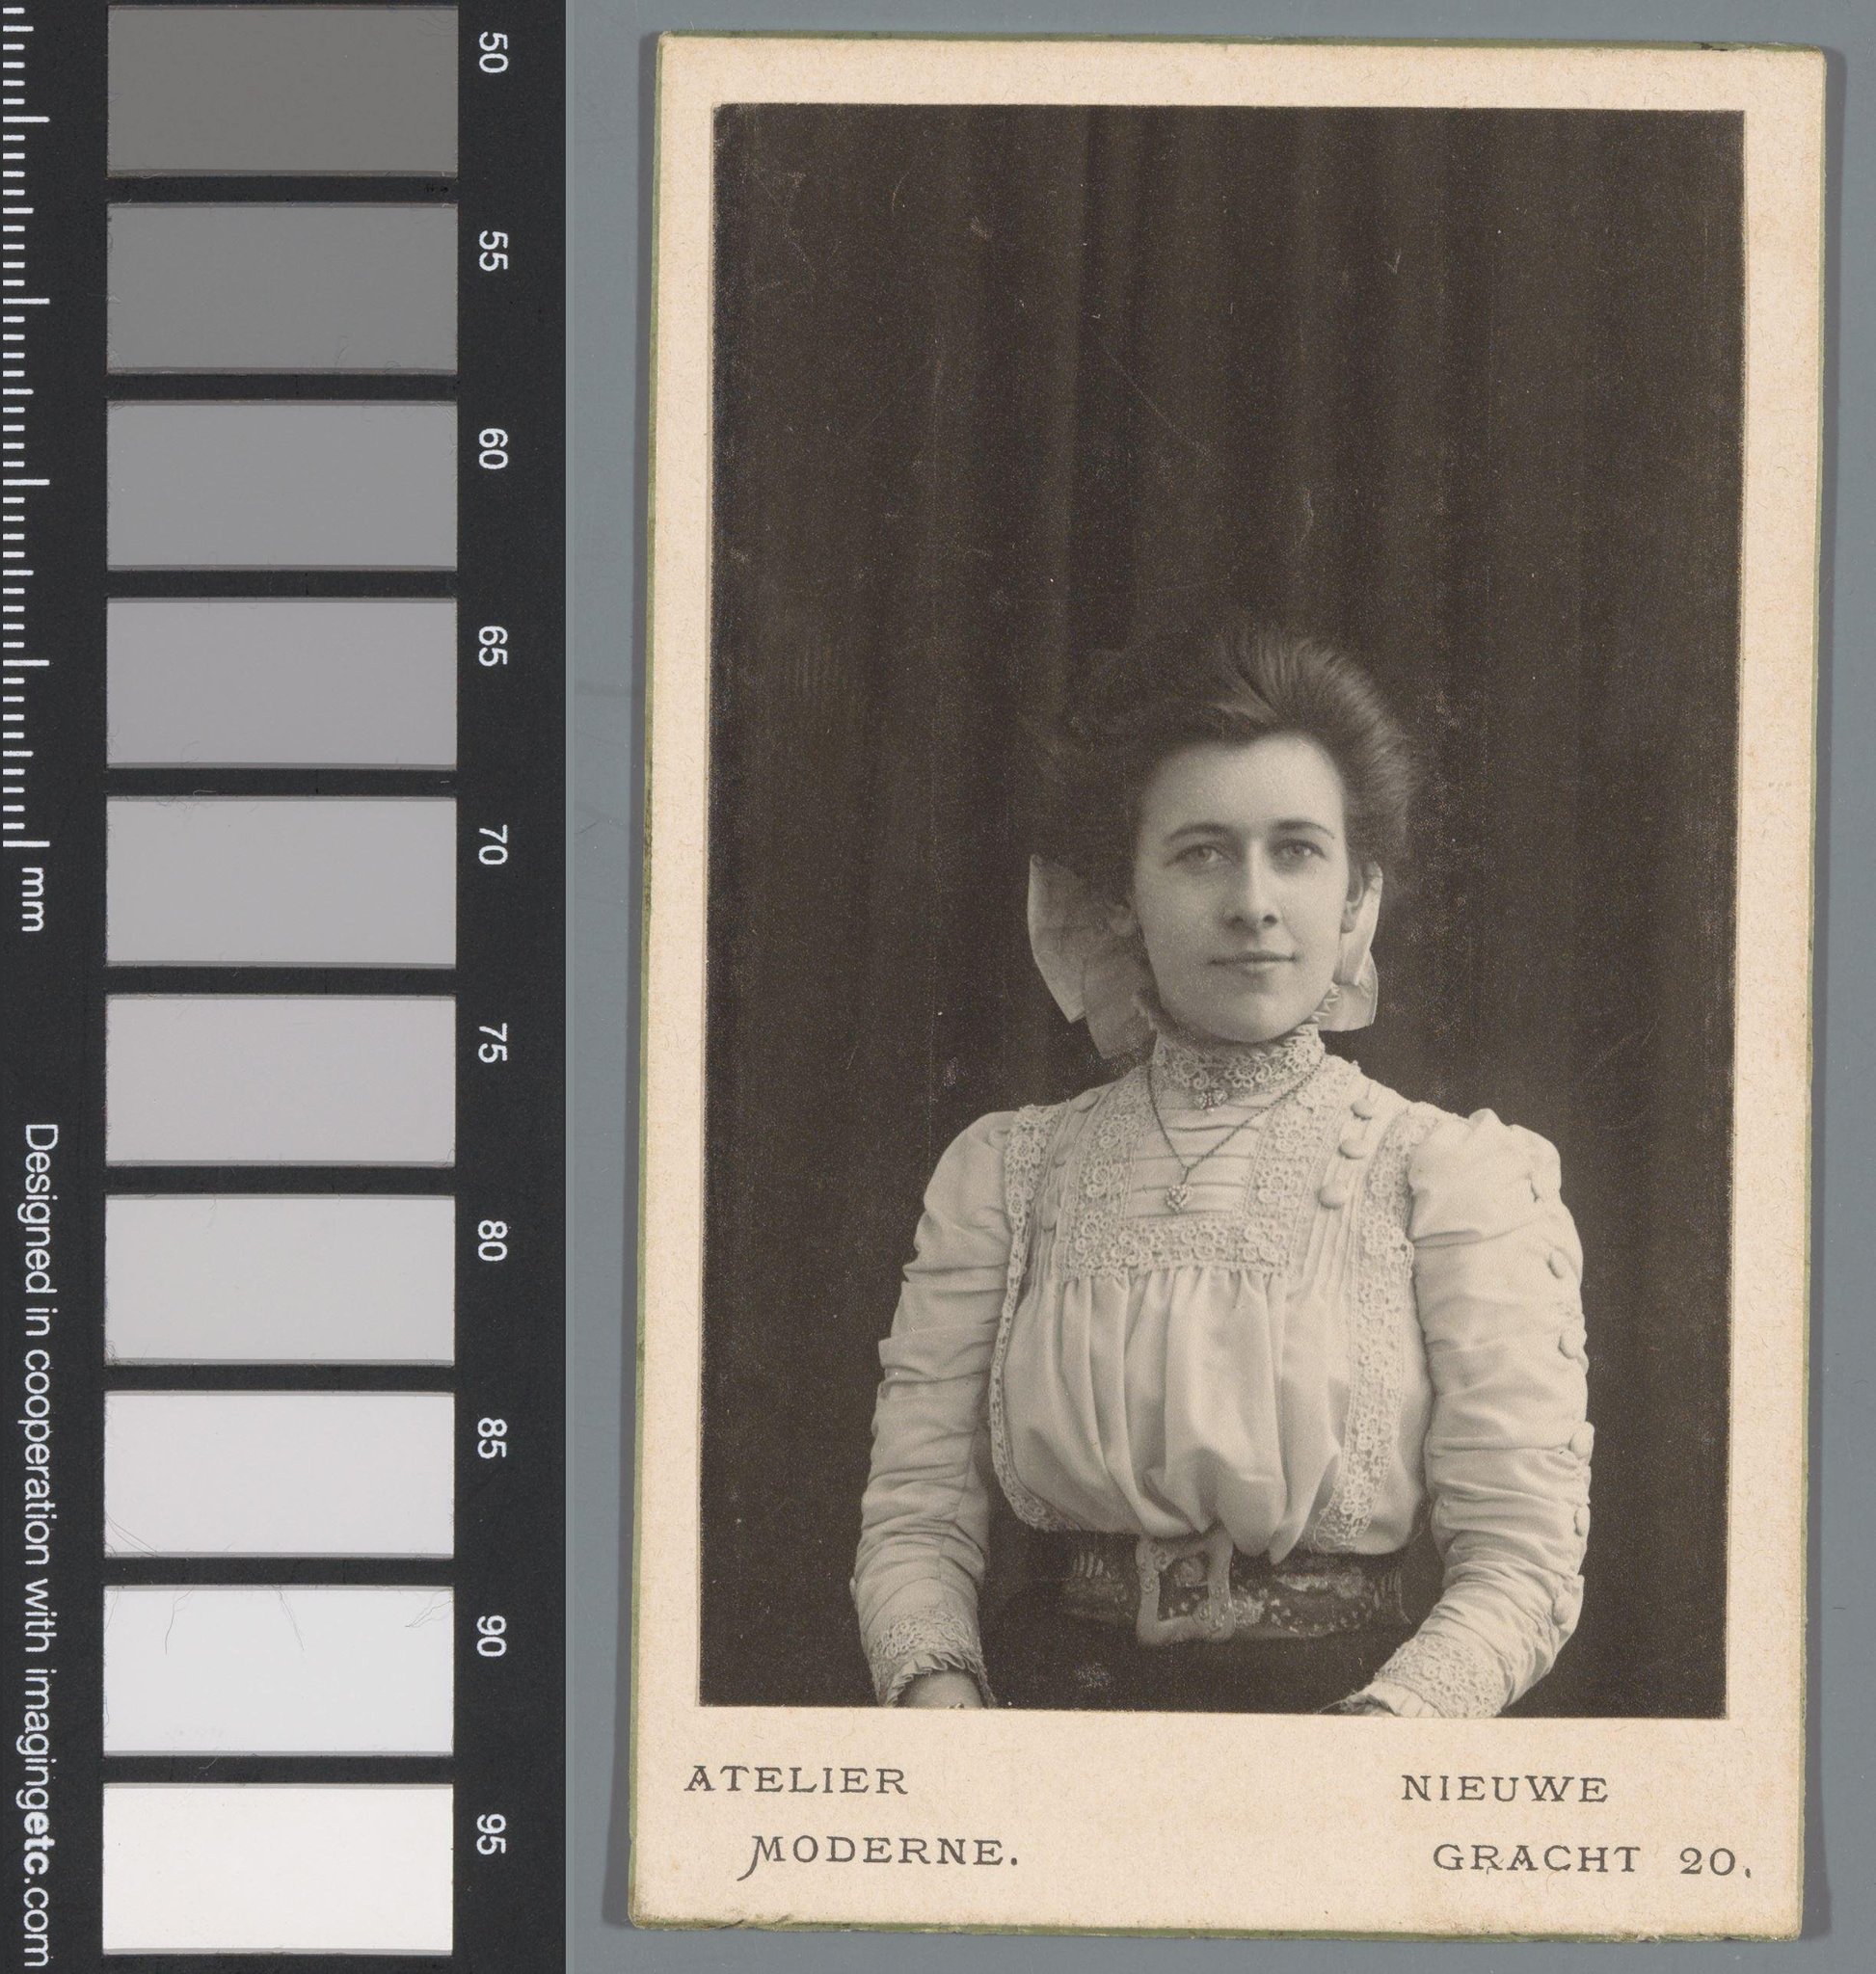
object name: carte de visite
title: Portret van een onbekende vrouw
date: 1895-1920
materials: cardboard, photographic support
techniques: matte daylight collodion silver print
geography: netherlands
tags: historical persons - bb - woman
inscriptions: address: ‘ATELIER/ MODERNE./ NIEUWE/ GRACHT 20.’